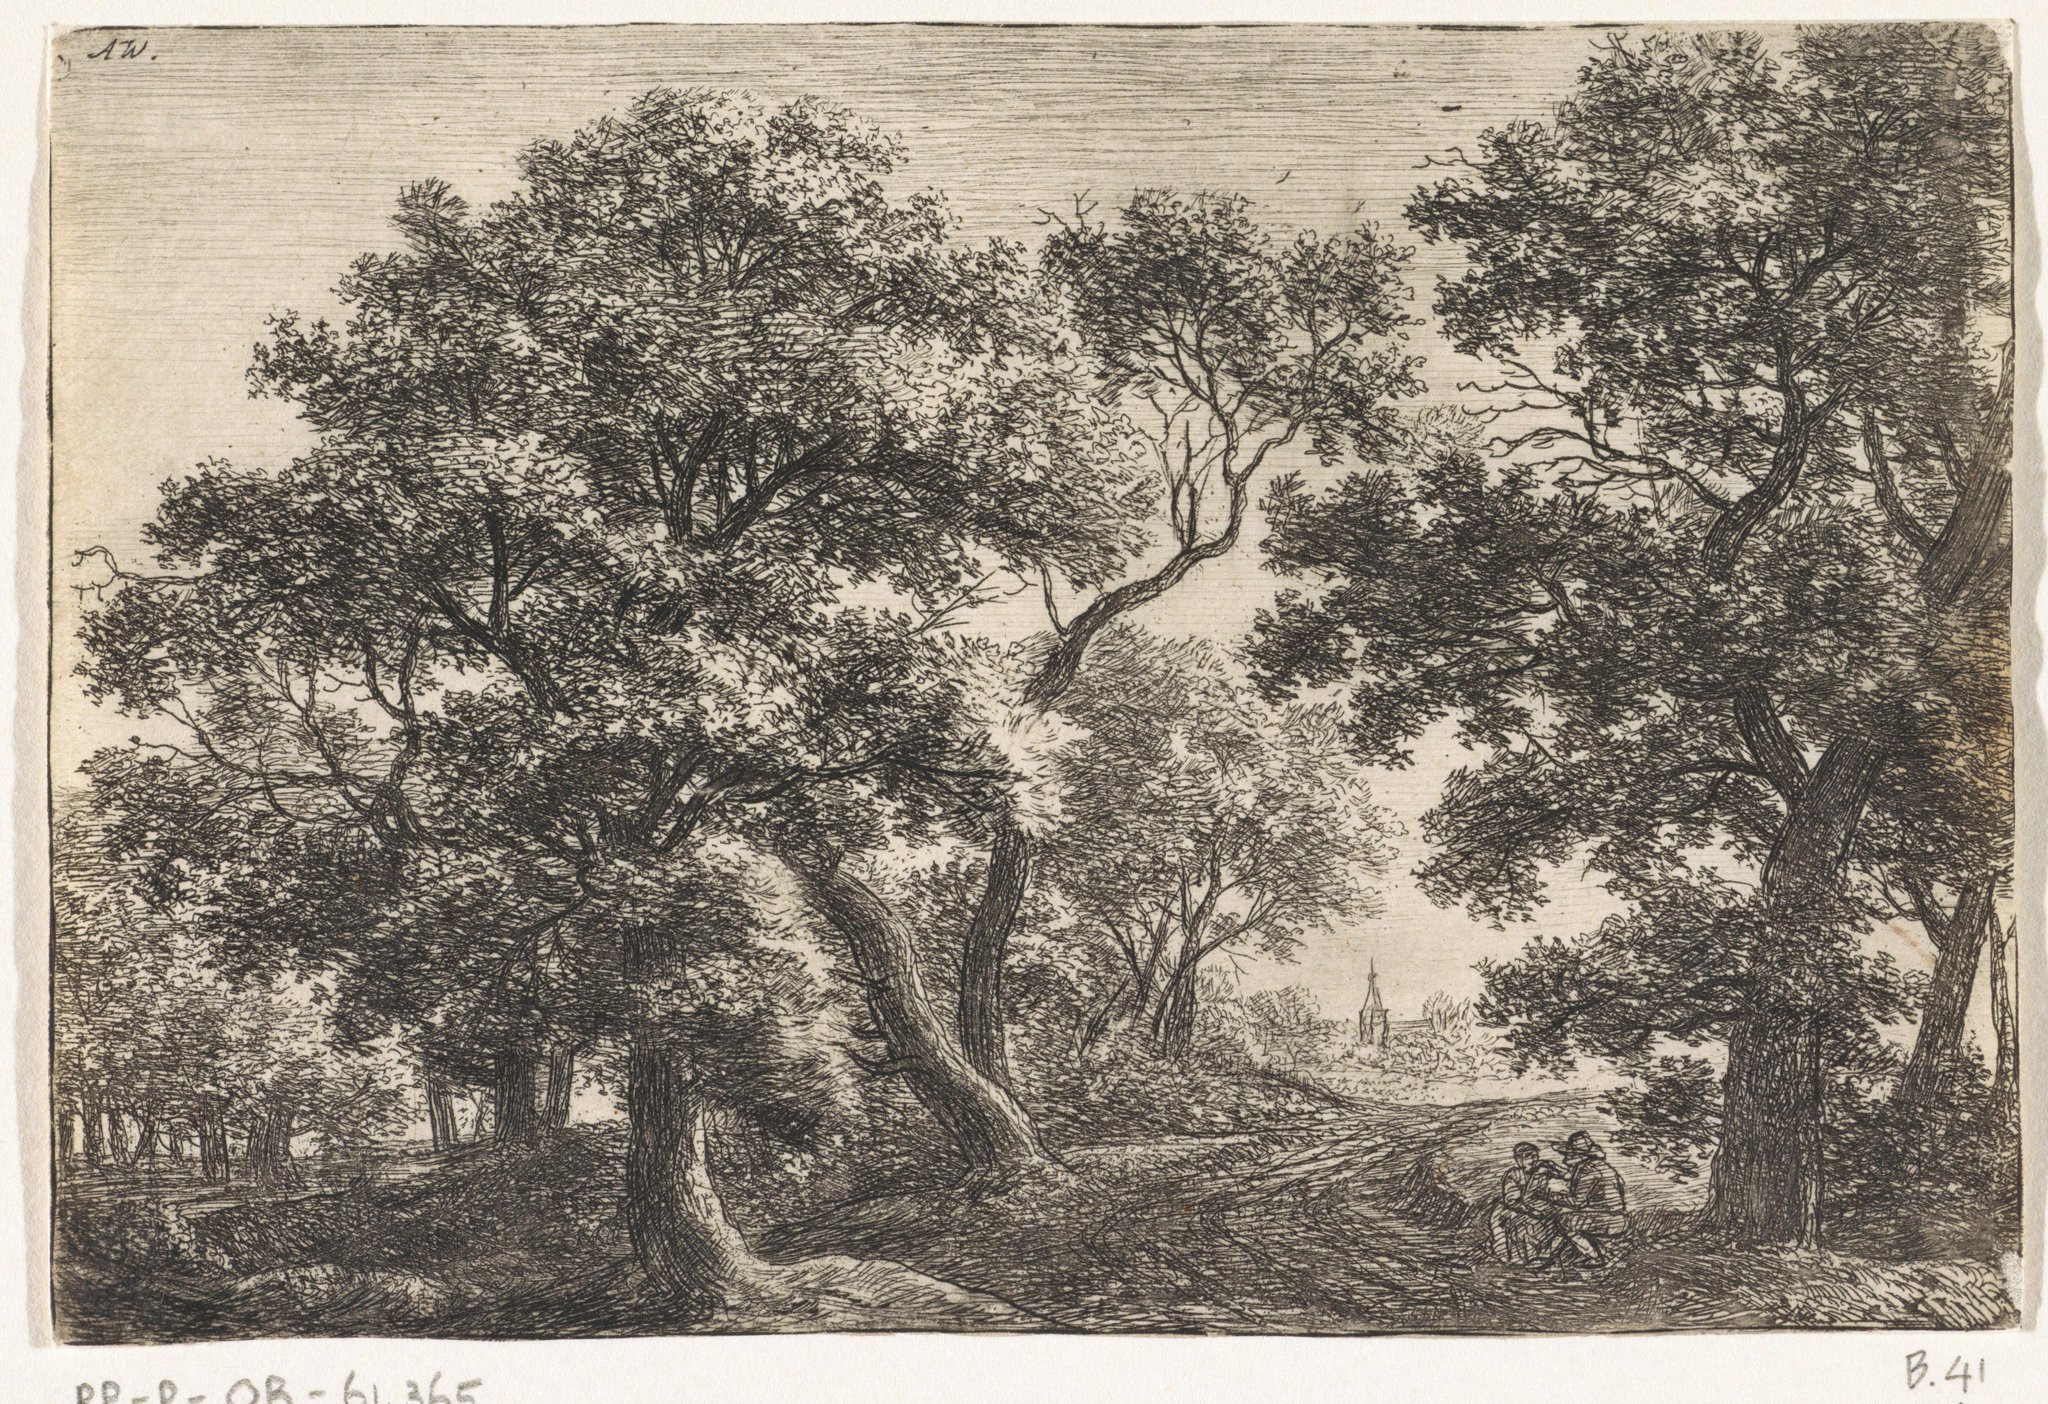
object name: print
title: Twee figuren onder een eik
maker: anthonie waterloo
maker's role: draughtsman, painter, print maker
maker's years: 1609-1690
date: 1630-1663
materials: paper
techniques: etching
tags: trees: oak, forest path or lane, sitting on the ground, landscapes (+ landscape with figures, staffage), parts of church exterior and annexes: tower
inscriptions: collector's mark: Lugt 240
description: Langs een bospad zitten twee figuren onder een eik. In de verte is een kerktoren te zien.